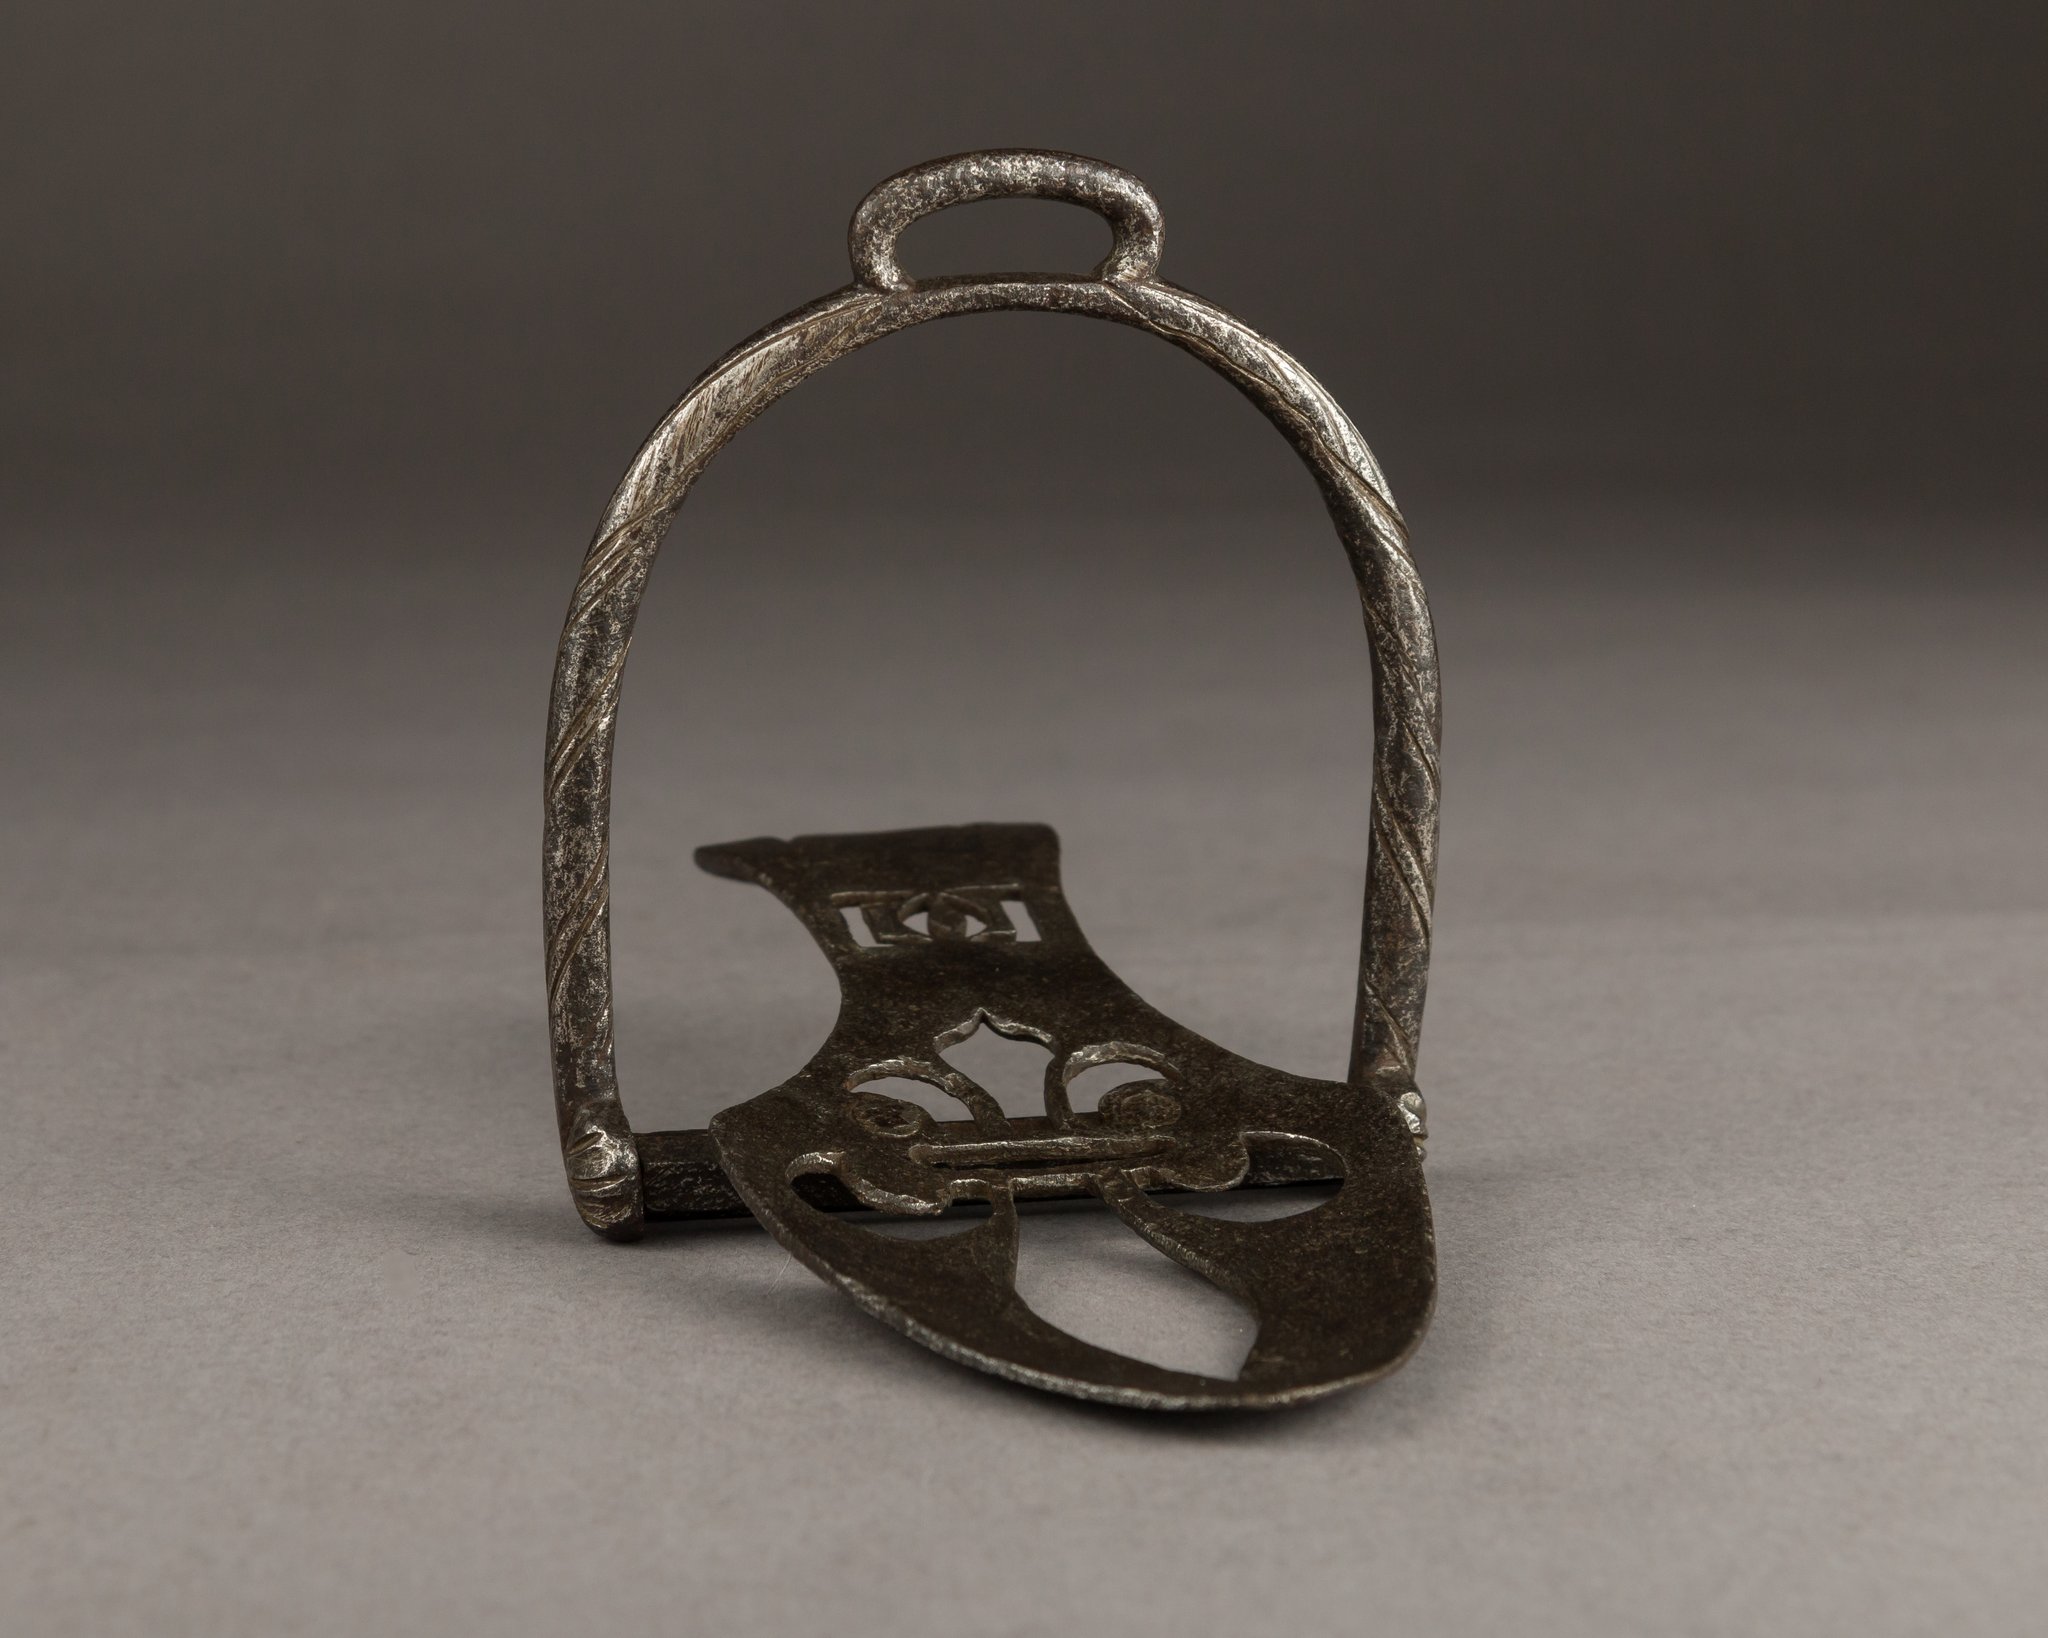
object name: stirrup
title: Lady's Stirrup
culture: french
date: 1767-1833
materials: iron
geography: france